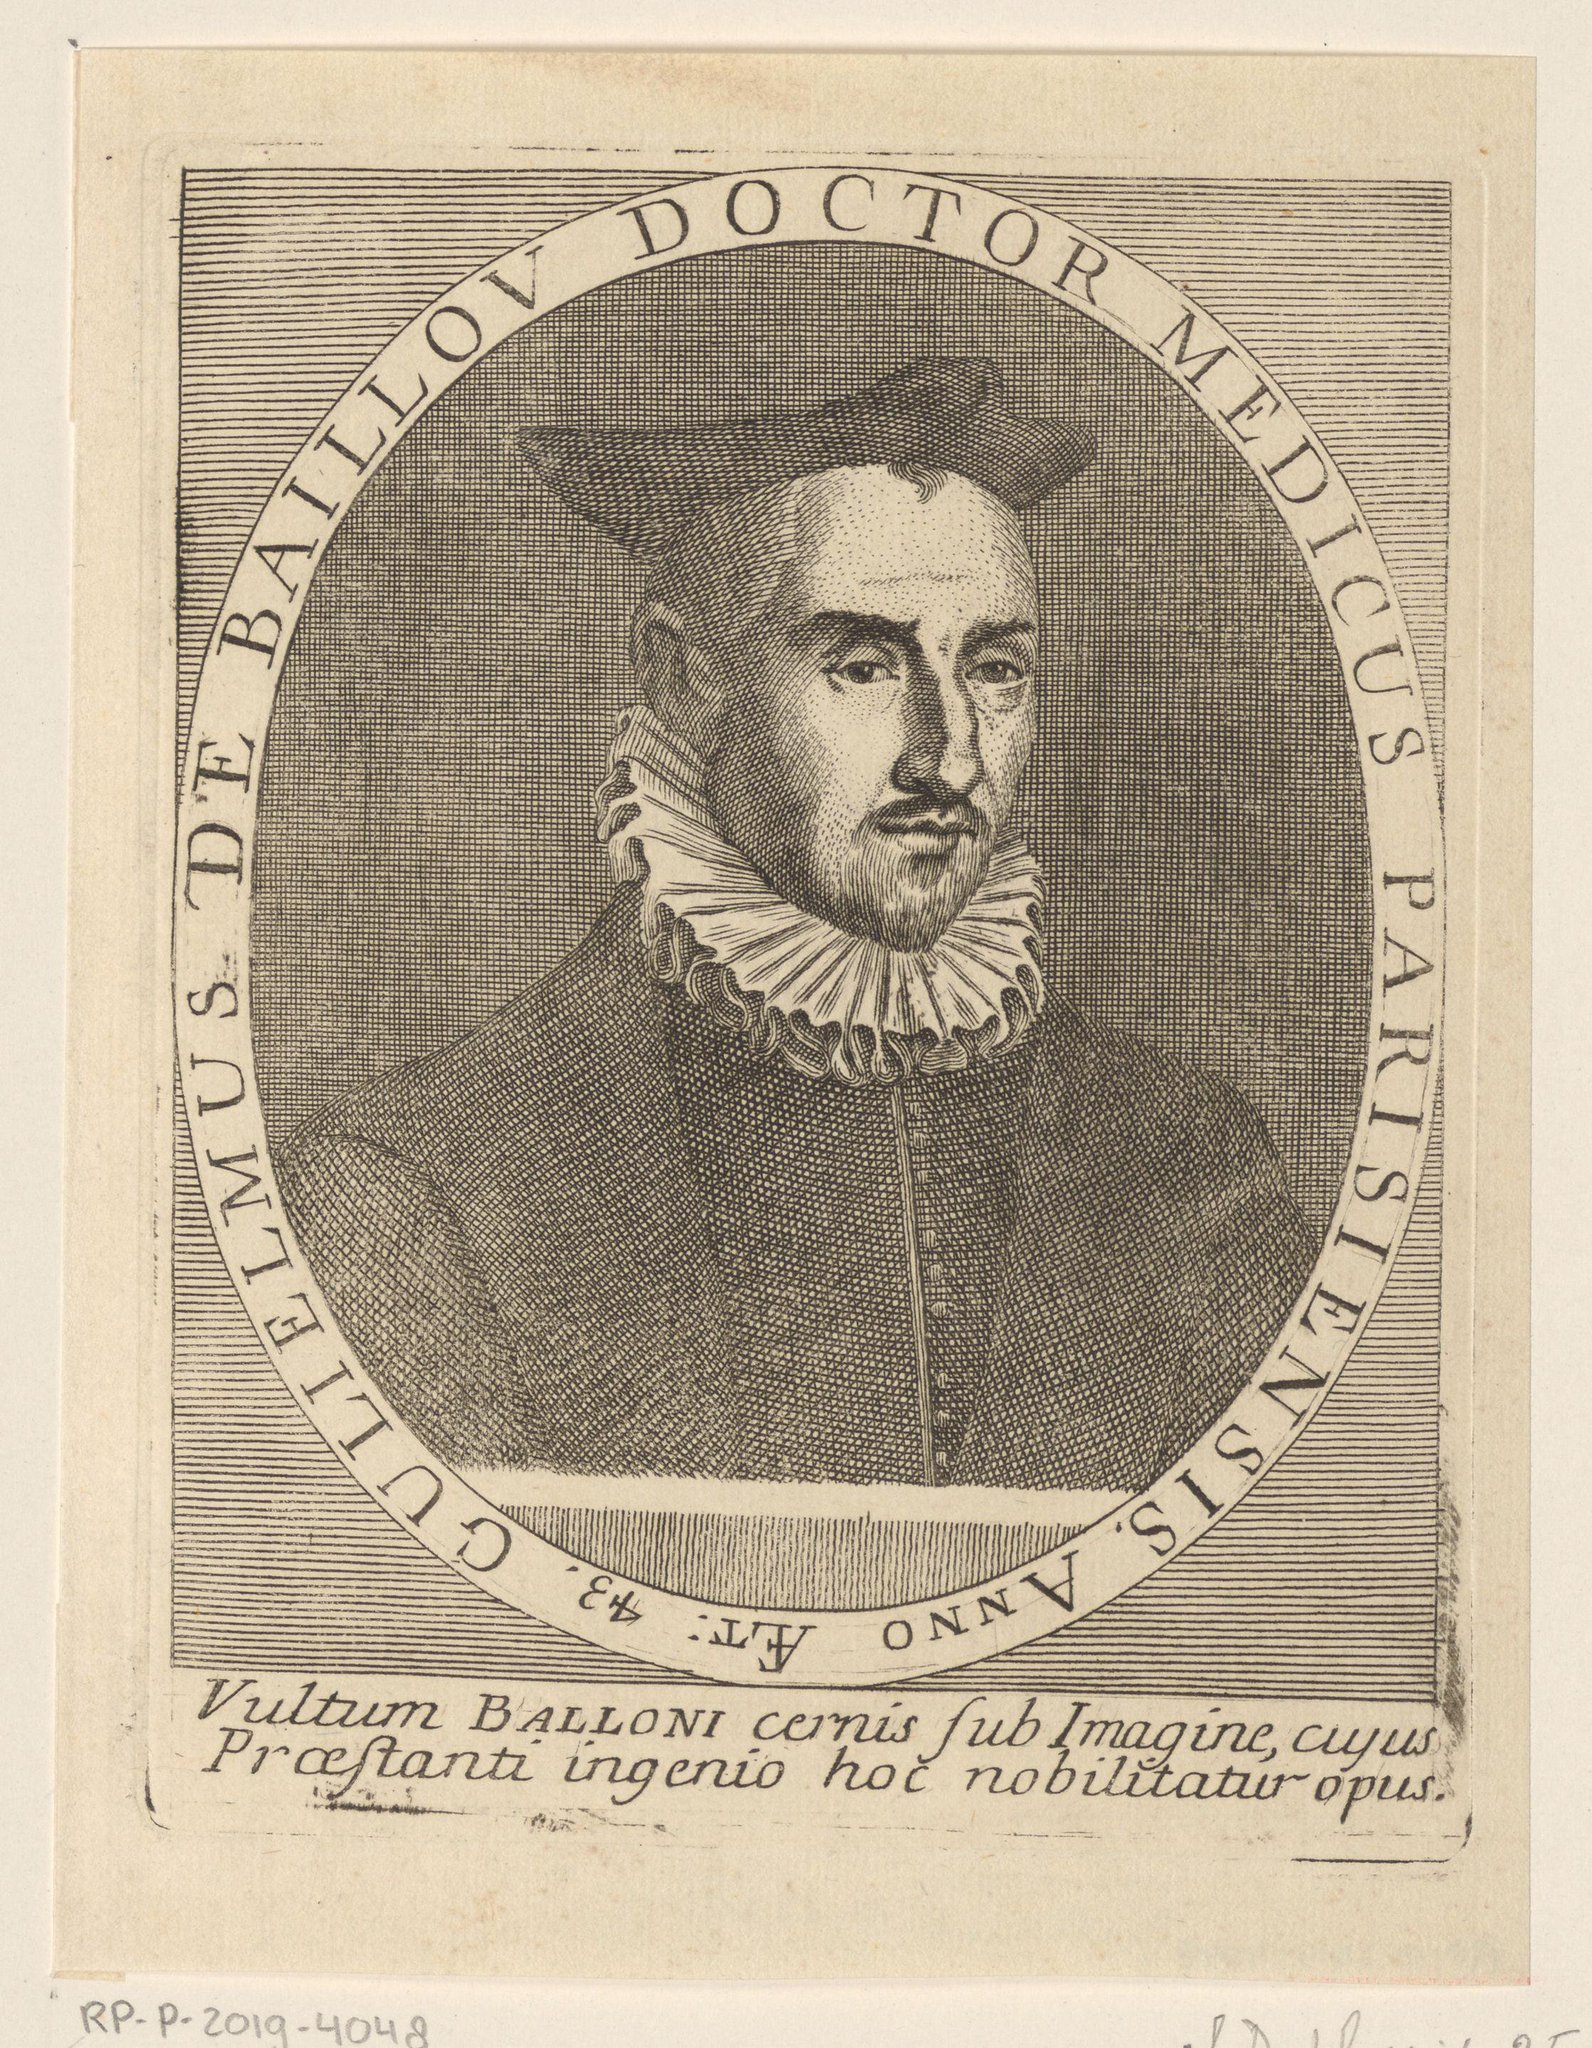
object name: book illustration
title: Portret van Guillaume de Baillou op 43-jarige leeftijd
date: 1734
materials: paper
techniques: engraving, etching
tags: paris, historical persons, physician, doctor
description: Prent uit: Baillou, Guillaume de. Opera omnia medica (...) Epidemiorum et ephemeridum libri duo (...). Venetië: Angelum Jeremiam, 1734, dl. 1. Prent ook gebruikt in andere edities.